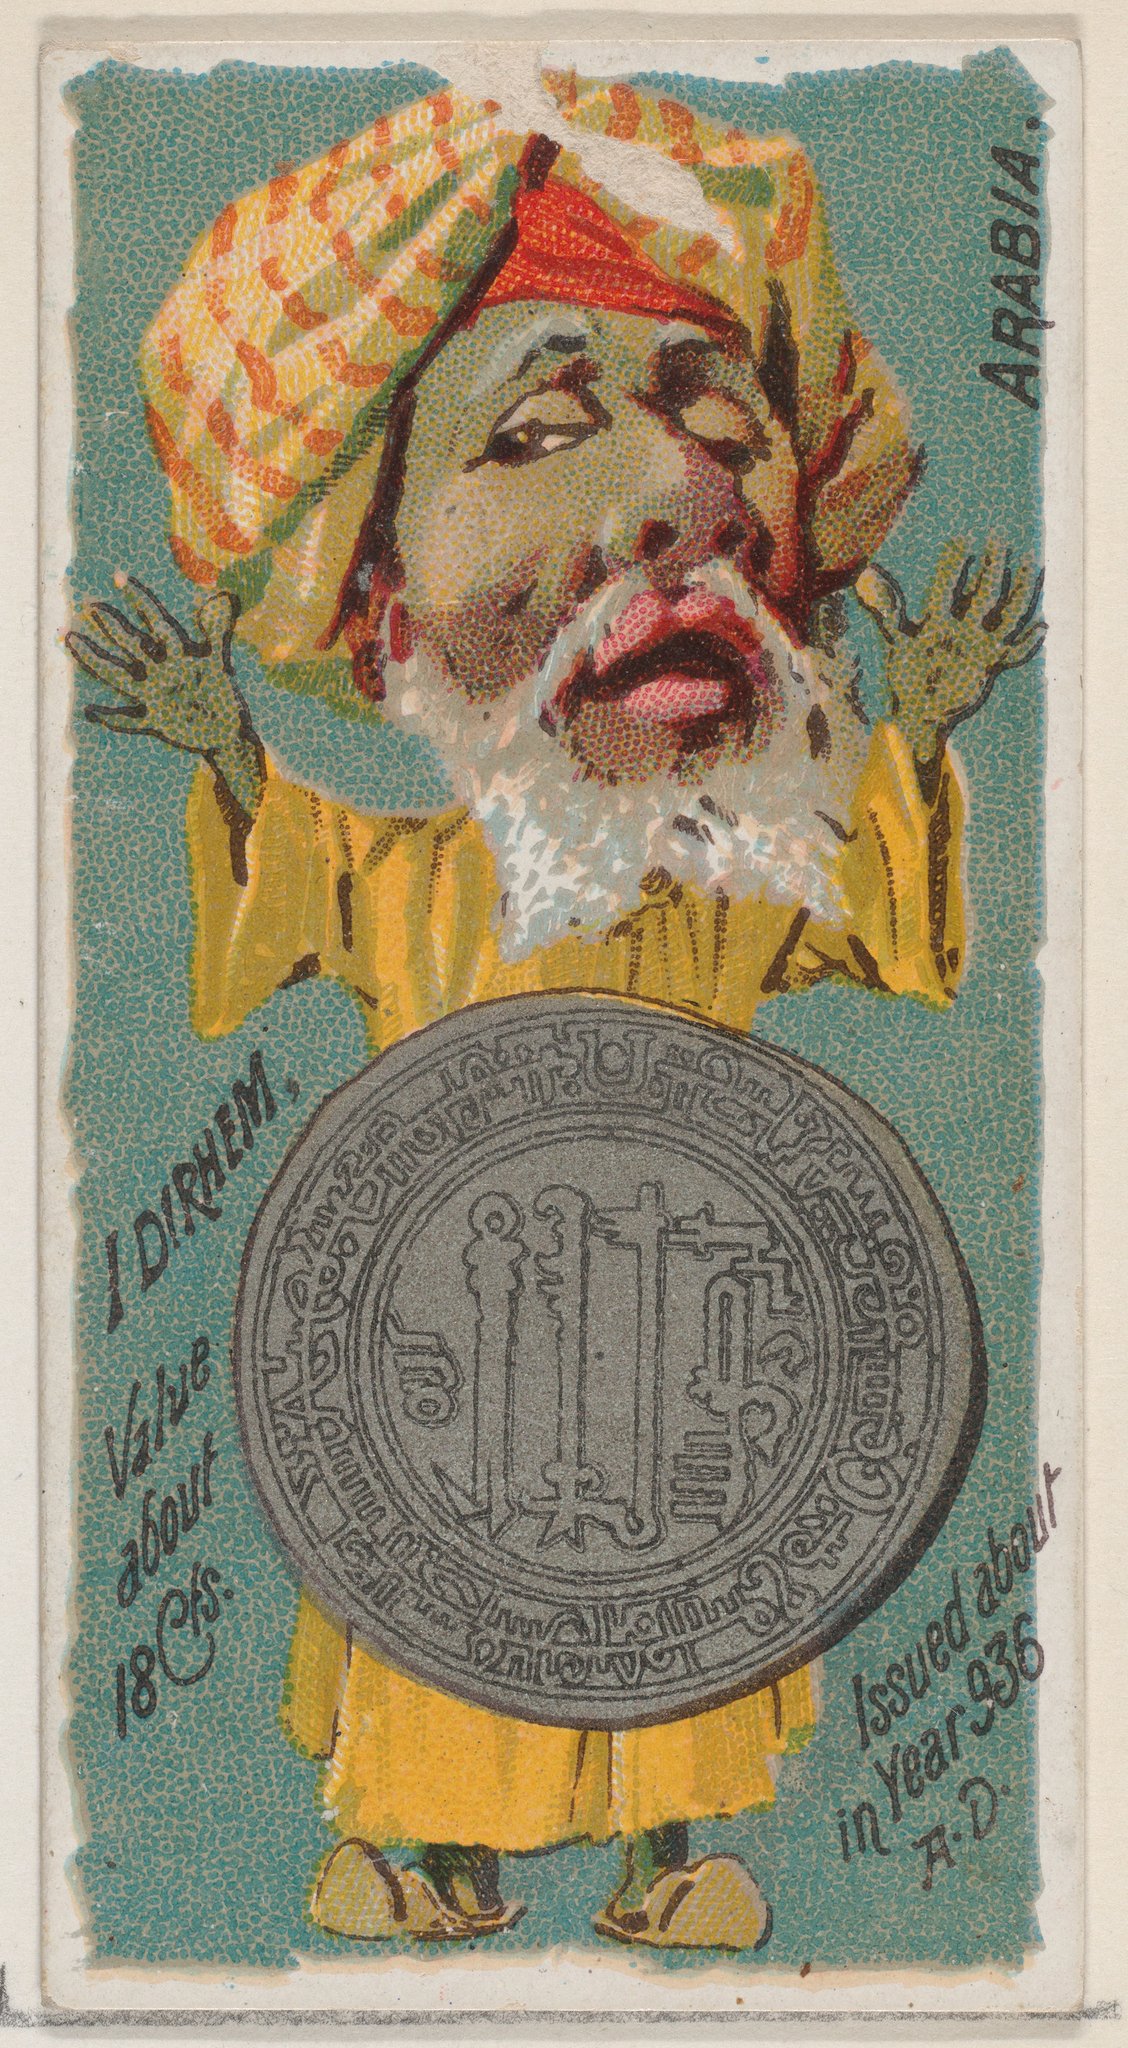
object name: print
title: Caricatured Arabian, 1 Dirhem, from the series Coins of All Nations (N72, variation 2) for Duke brand cigarettes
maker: w. duke, sons & co.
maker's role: publisher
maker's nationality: american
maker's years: 1870-1920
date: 1889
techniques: color lithograph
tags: men,coins